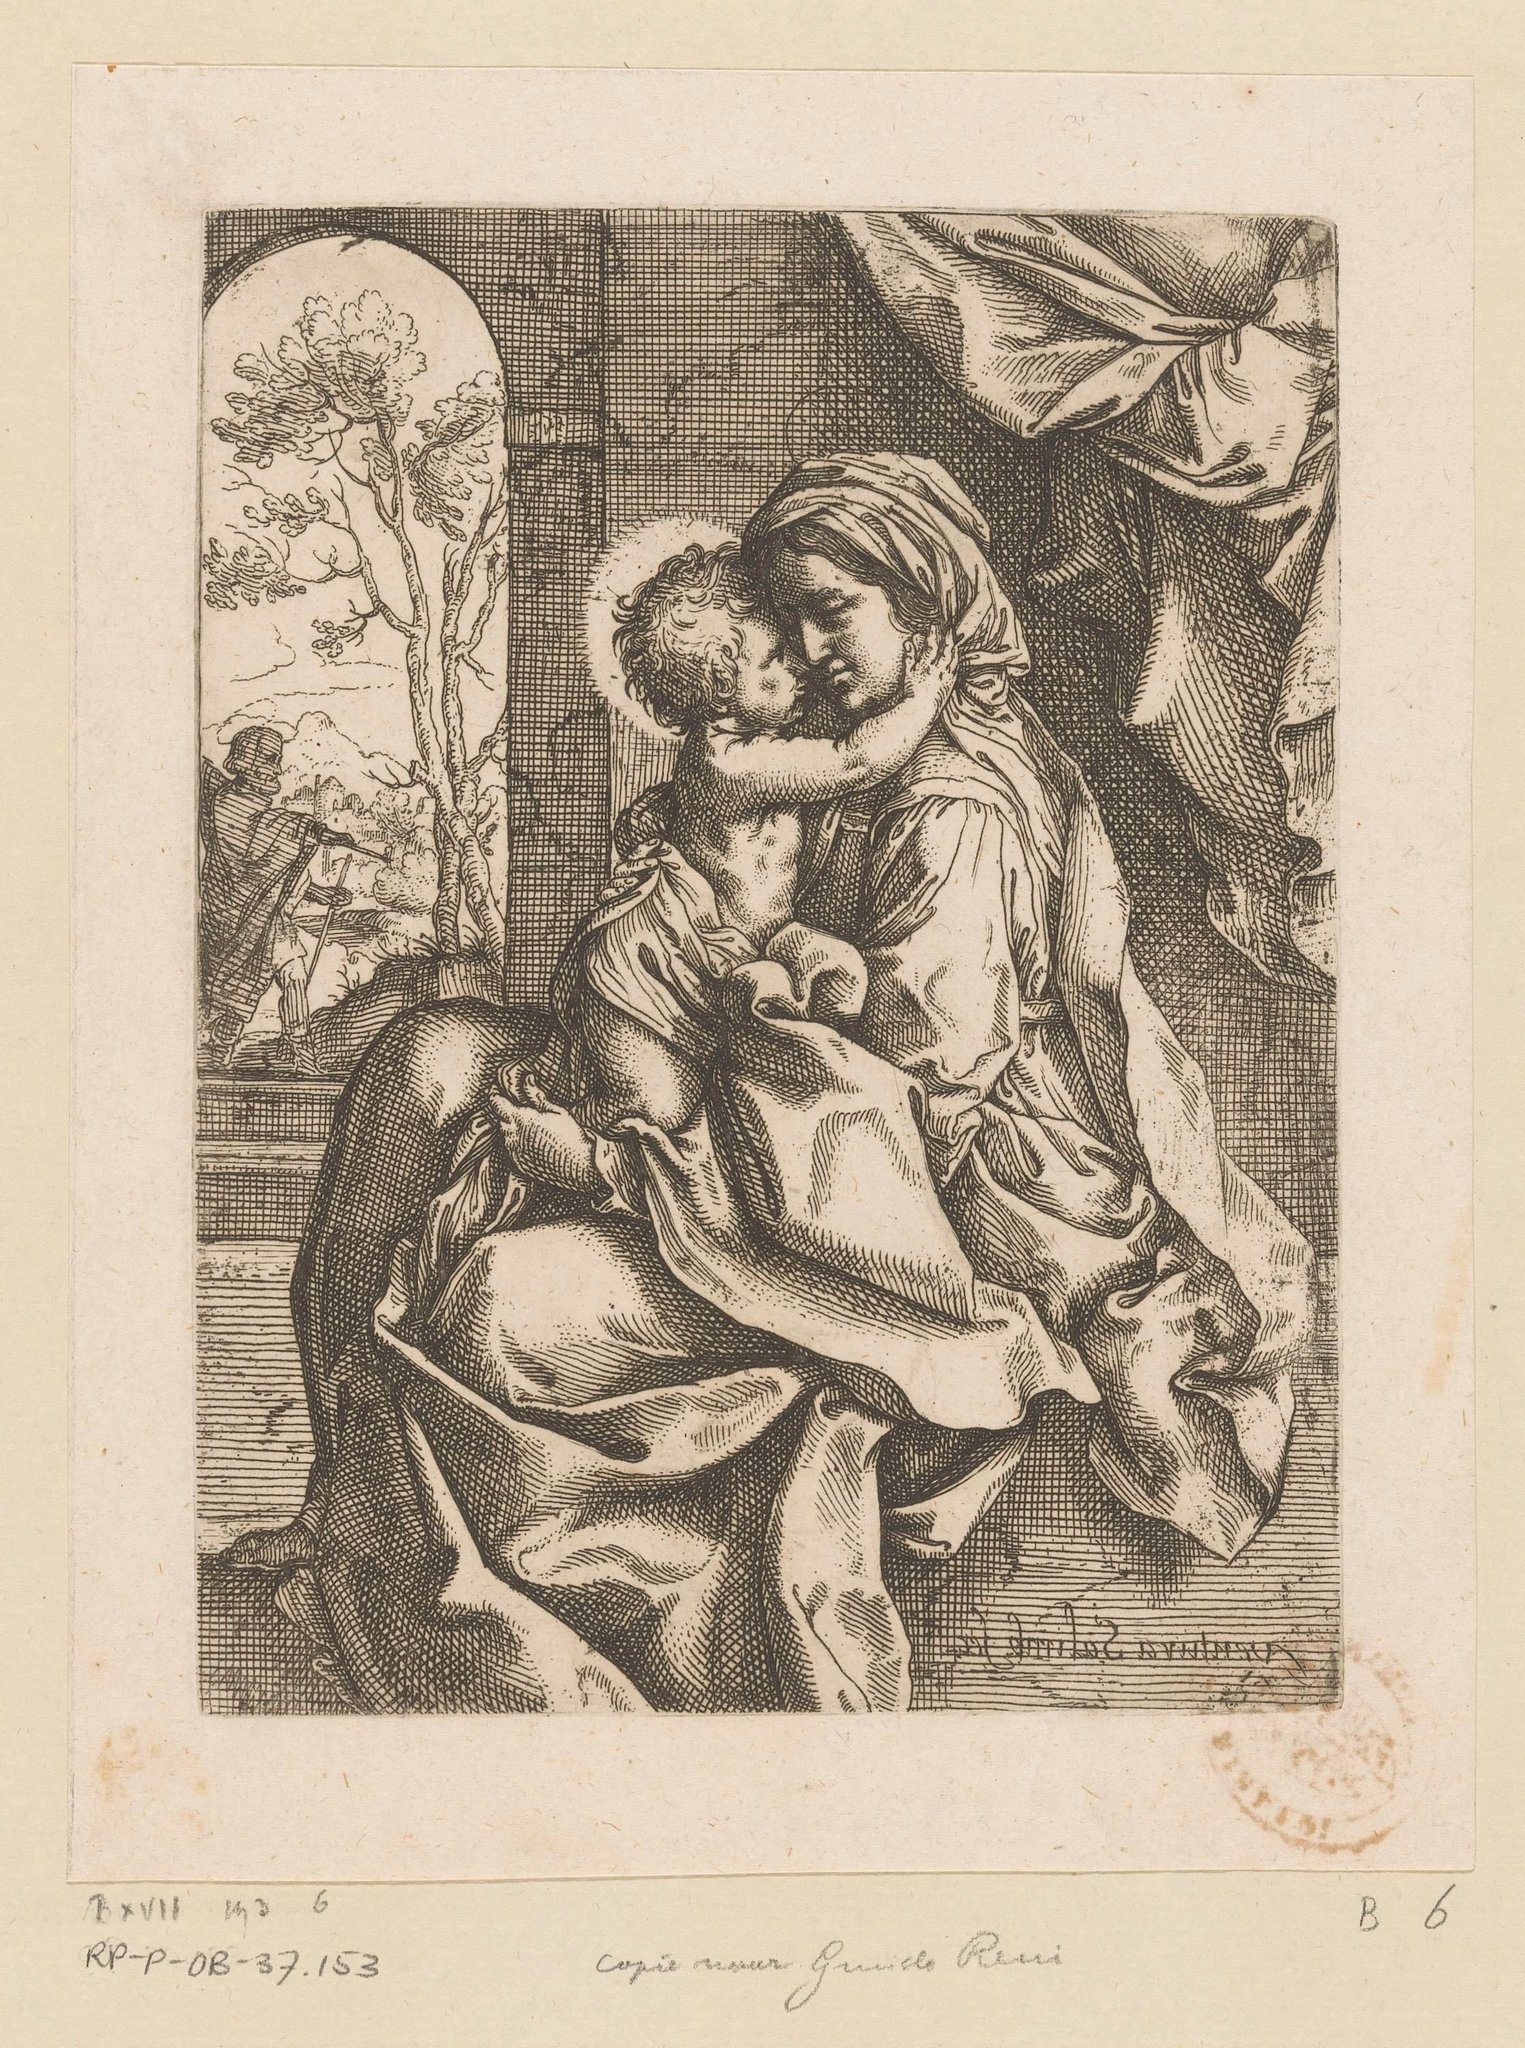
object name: print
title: Maria met Kind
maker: ventura salimbeni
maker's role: draughtsman, painter, print maker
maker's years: 1568-1613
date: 1578-1613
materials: paper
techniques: etching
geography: italy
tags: madonna: i.e. mary with the christ-child, holy family, and derived representations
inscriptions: collector's mark: Lugt 240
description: Maria zit met het Christuskind op schoot in een ruimte. Rechts een draperie. Op de achtergrond links staat Jozef.